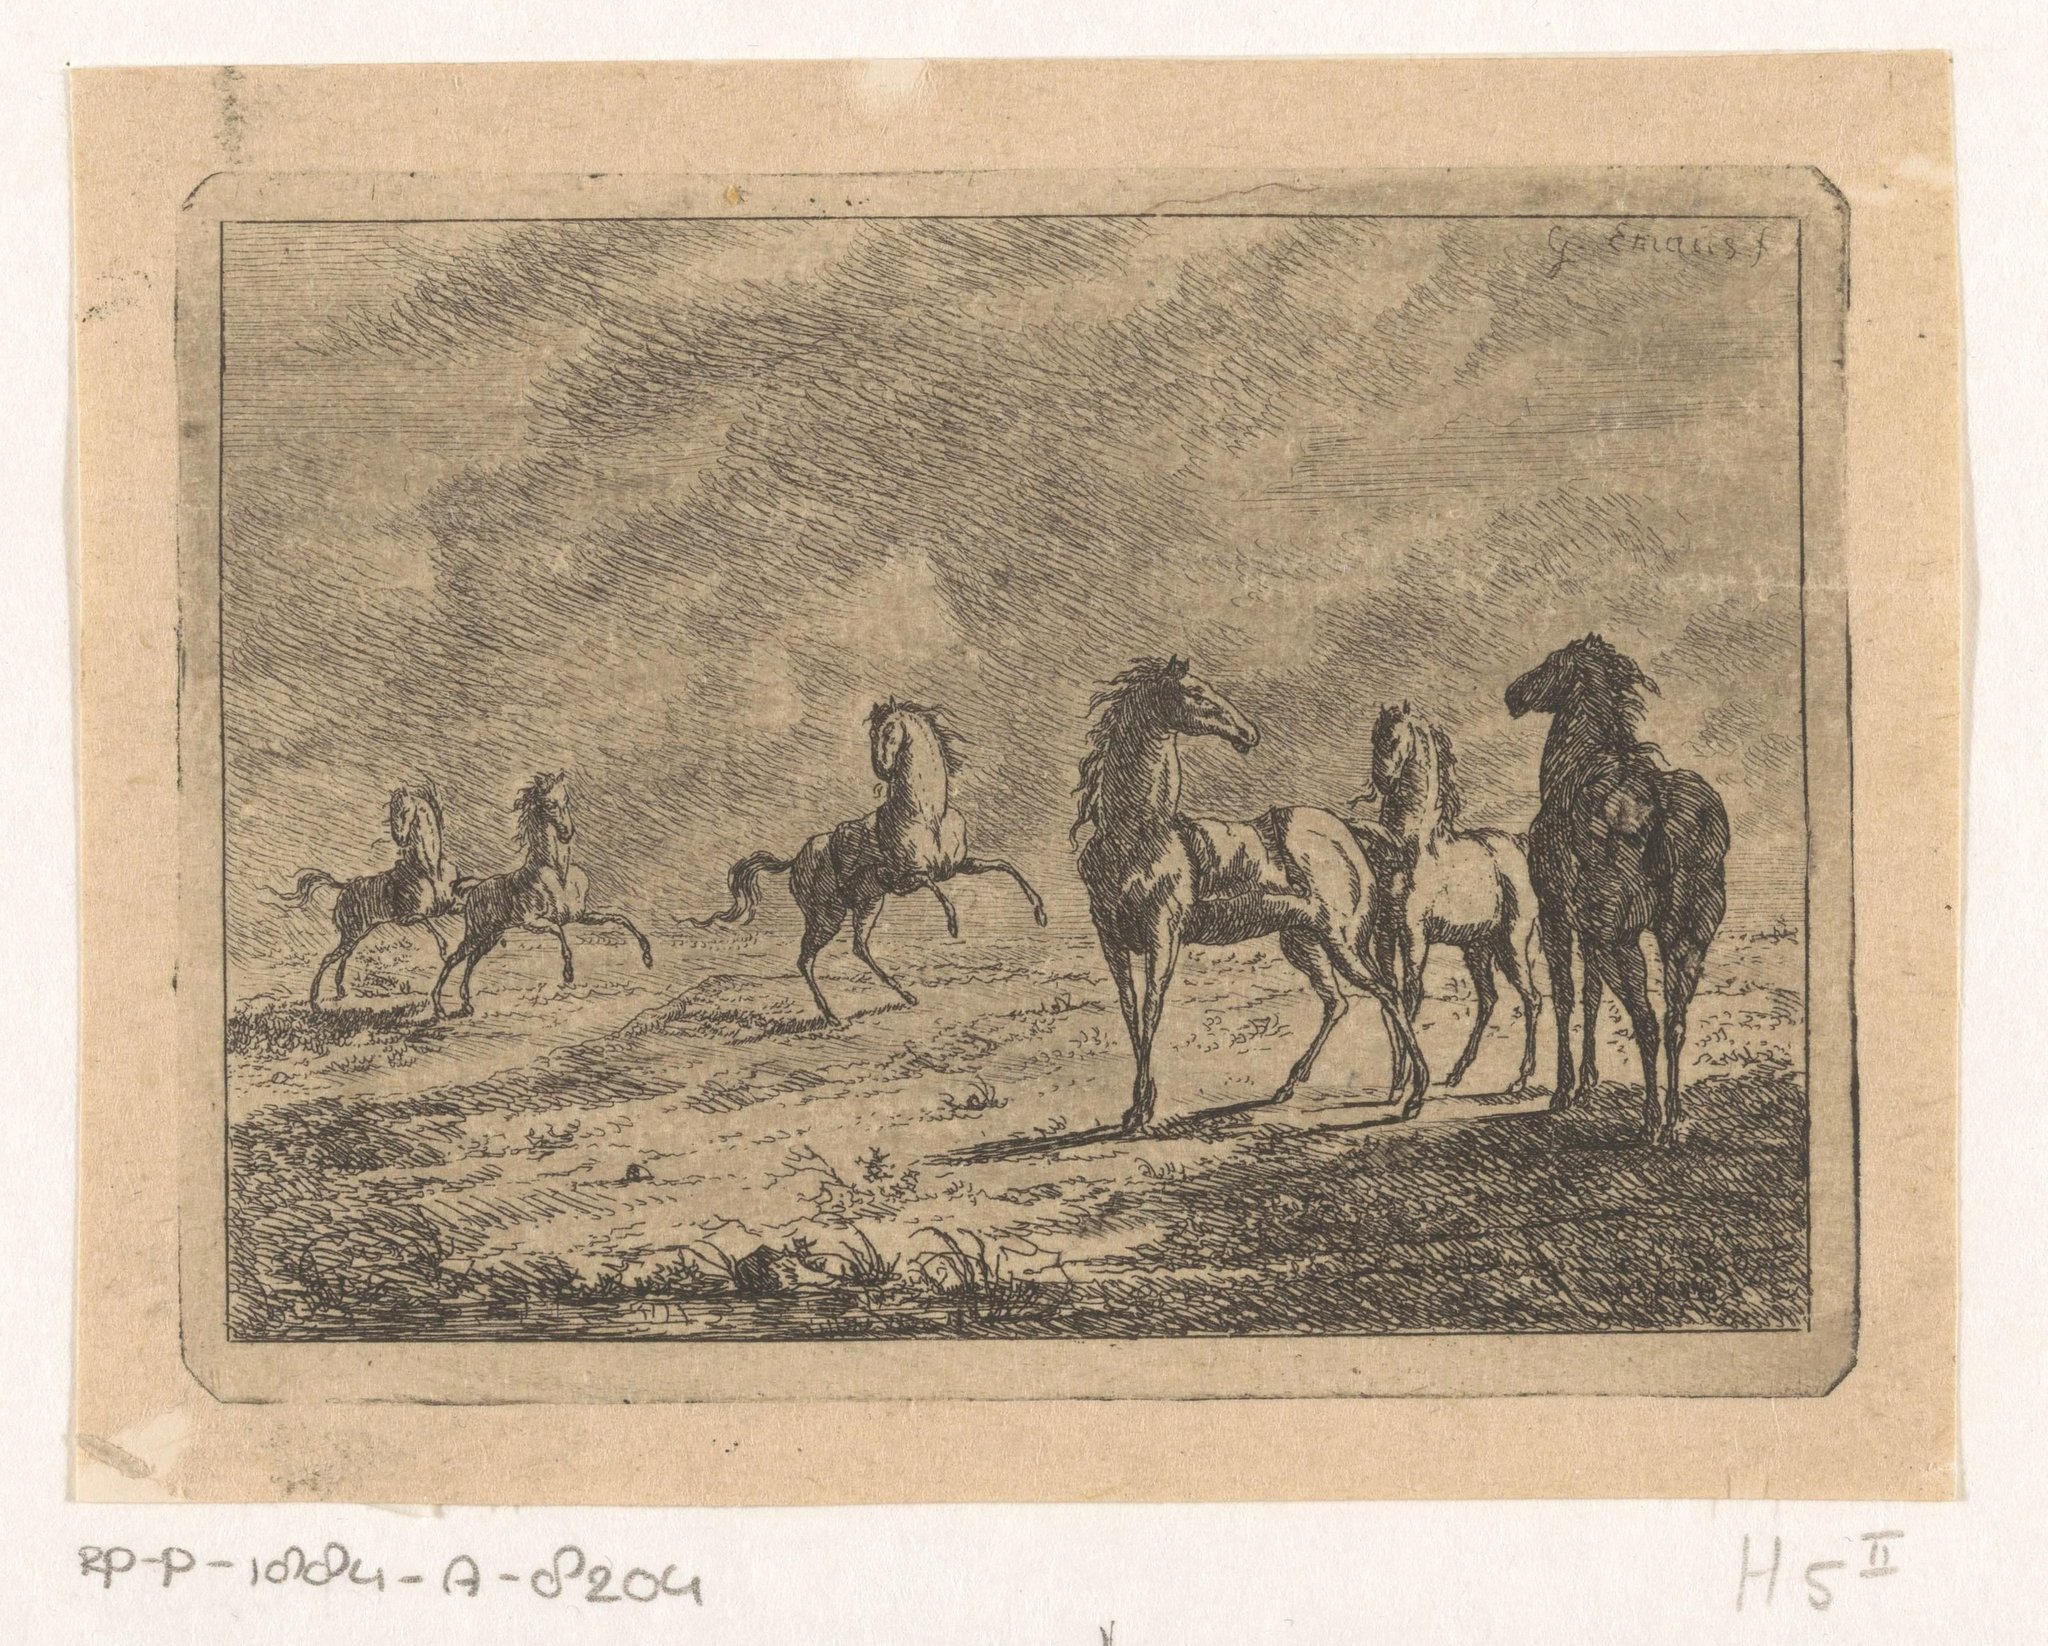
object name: print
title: Kudde wilde paarden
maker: gerardus emaus de micault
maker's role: draughtsman, print maker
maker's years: 1798-1863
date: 1813-1863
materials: paper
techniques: etching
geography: netherlands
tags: horse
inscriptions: collector's mark: Lugt 2228